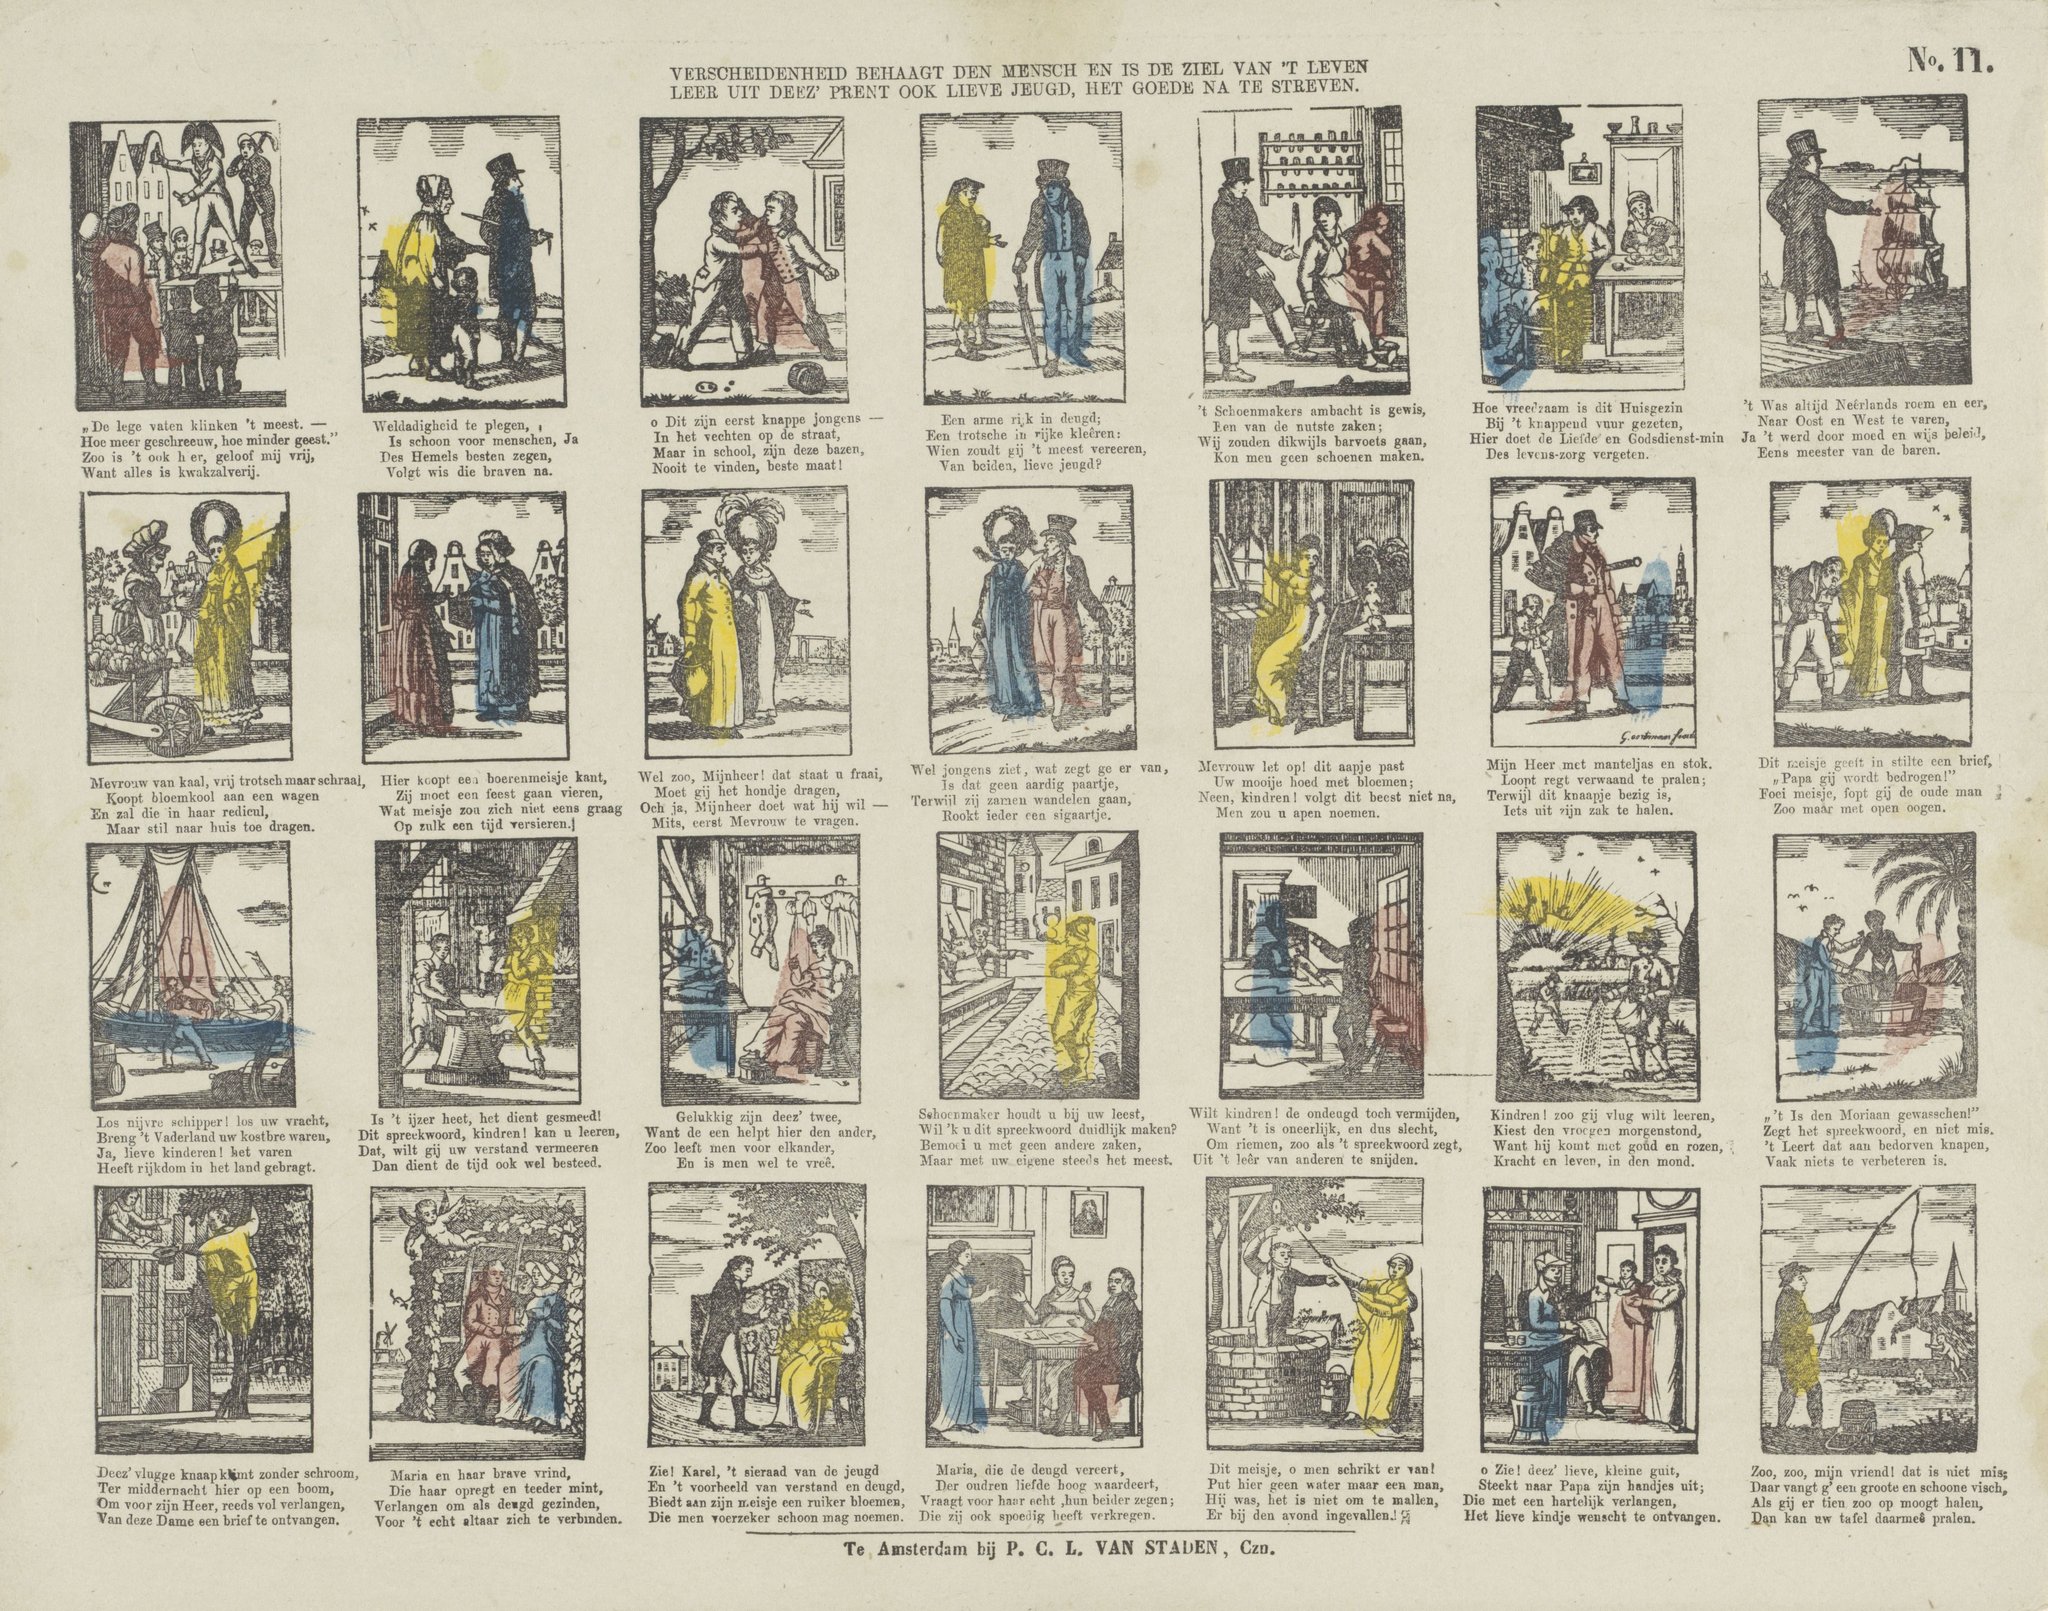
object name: print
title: Verscheidenheid behaagt den mensch / En is de ziel van 't leven, / Leer uit deez' prent ook lieve jeugd, / Het goede na te sneven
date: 1850-1870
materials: paper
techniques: colour, letterpress printing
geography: netherlands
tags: craft-production, skilled handiwork, farmers, working class, labourers, crafts and industries, fighting, seaman: sailor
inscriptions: collector's mark: Lugt 2760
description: Blad met 28 voorstellingen van verschillende beroepen en bezigheden. Onder elke voorstelling een vers. Rechtsboven genummerd: No. 11.